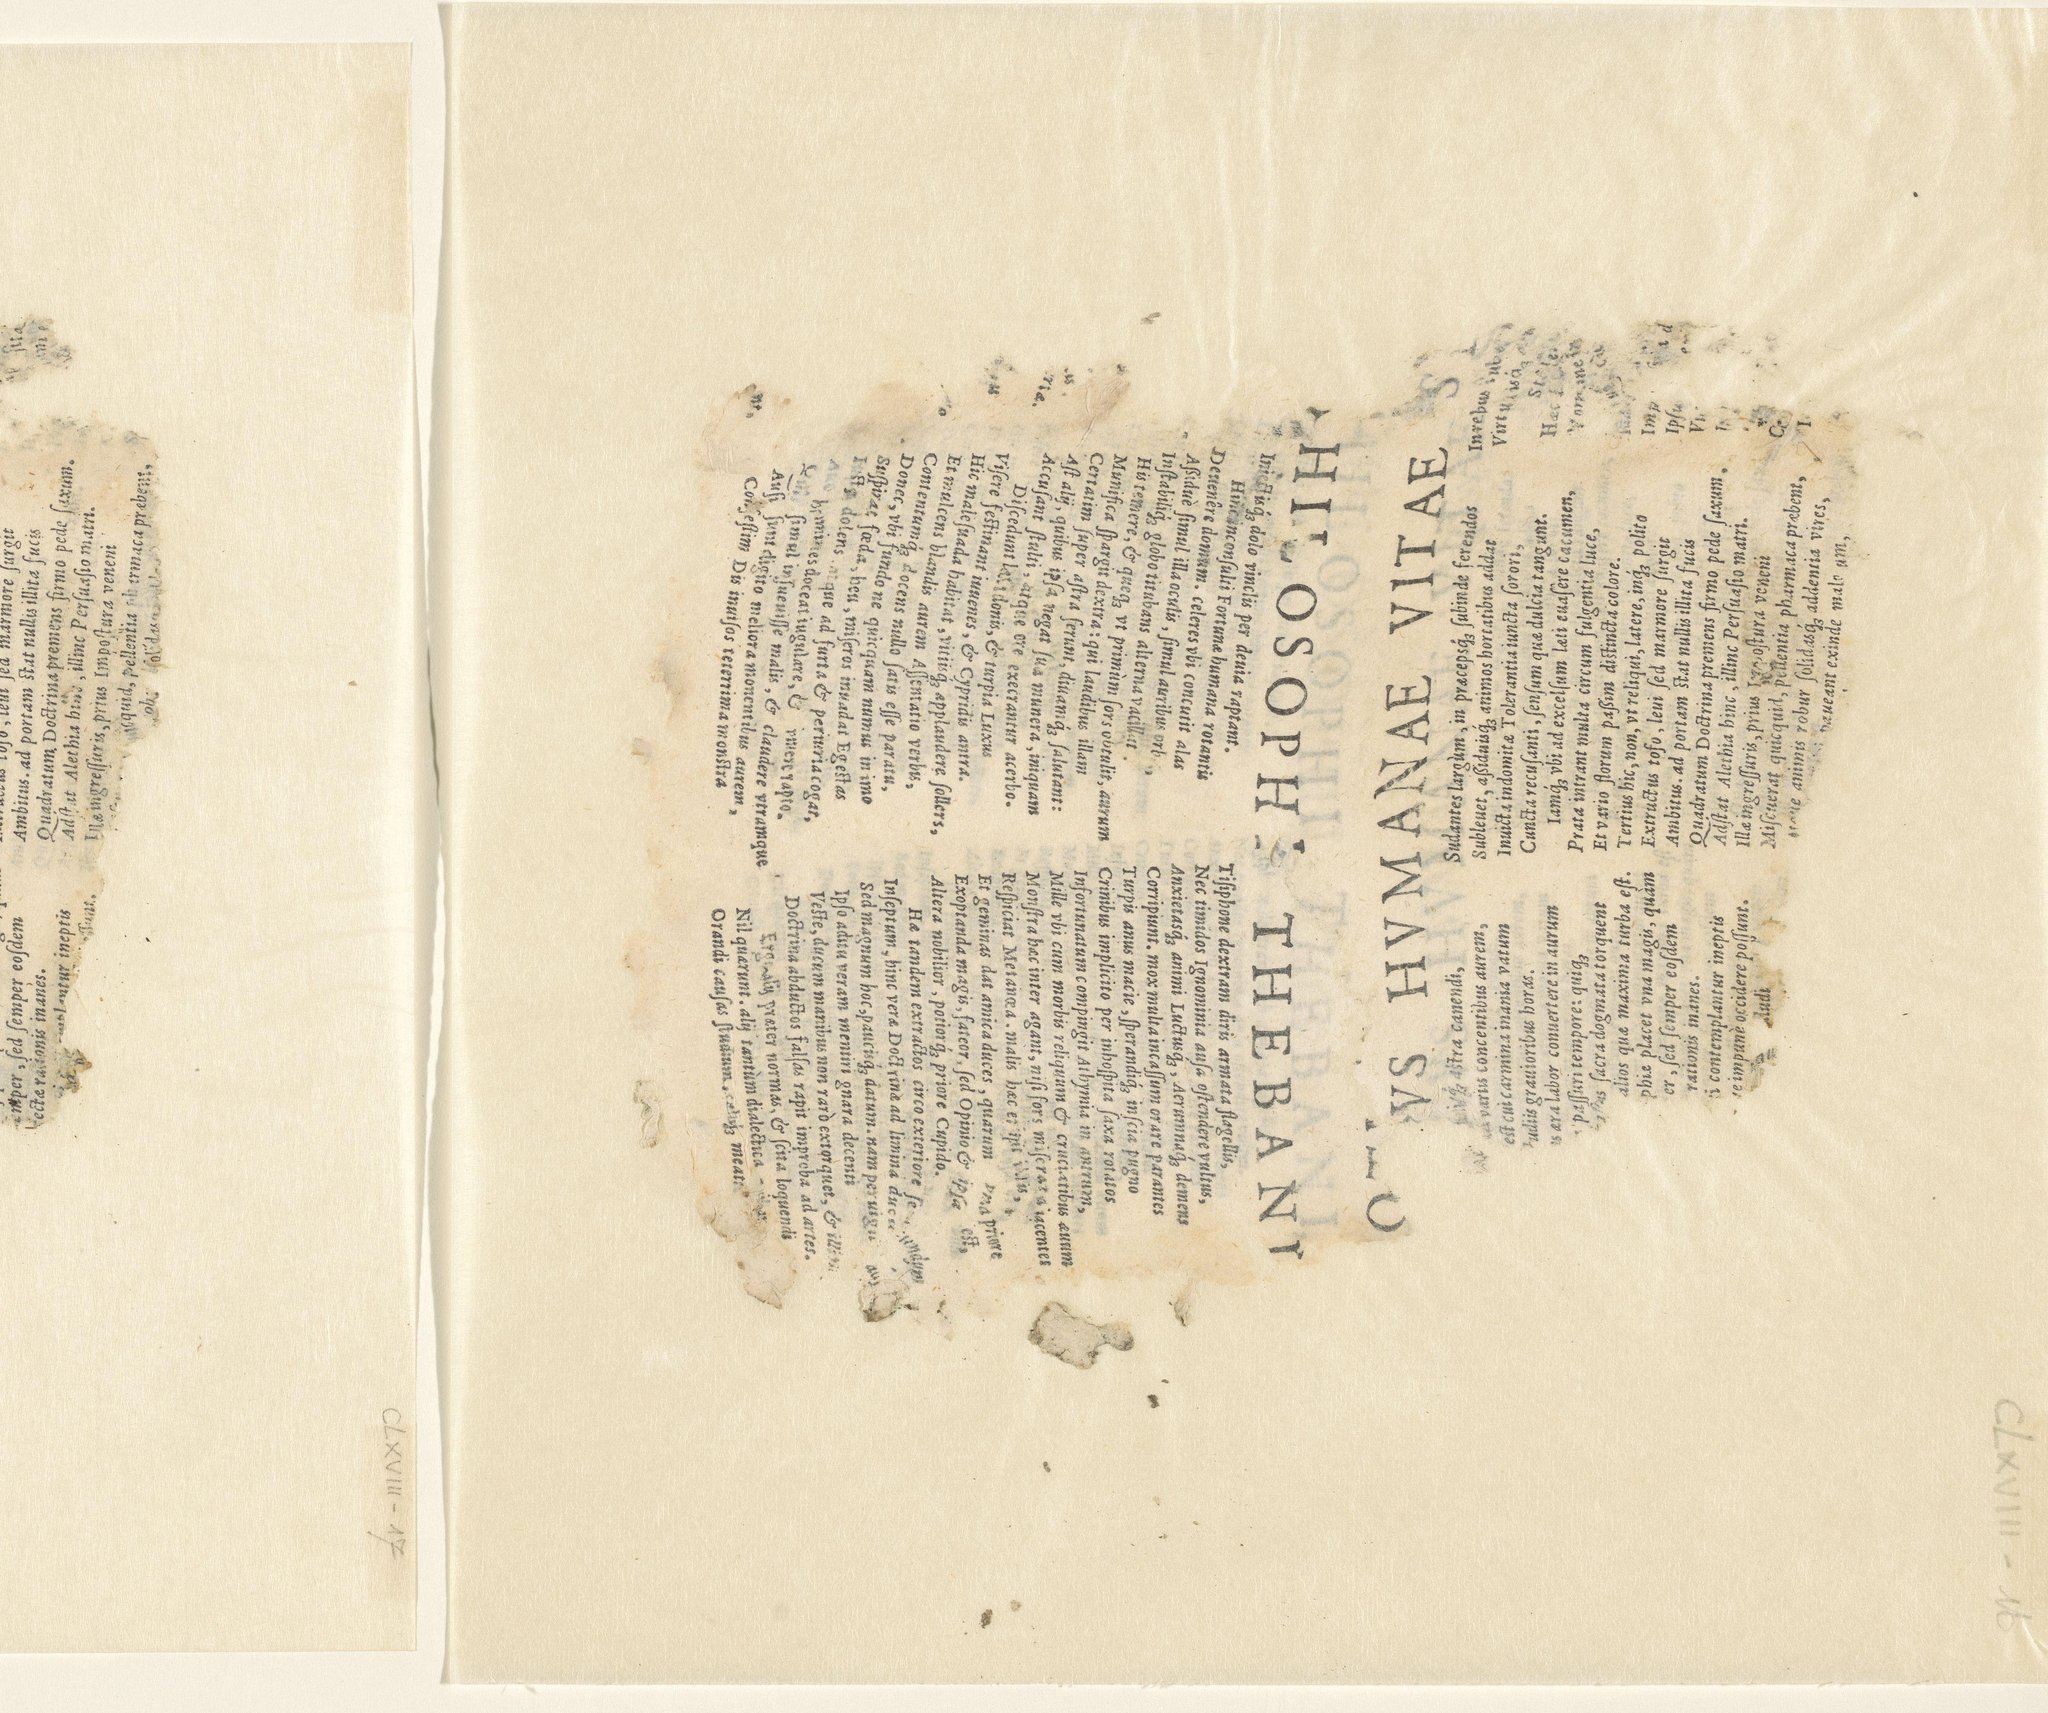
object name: text sheet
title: Tabula Cebetis Carta Vitae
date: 1561-1596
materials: paper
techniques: letterpress printing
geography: antwerp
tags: 'tabula cebetis'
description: Het tekstblad bestond origineel uit twee bladen. De prenten in de Nova Zembla collectie zijn tijdens een expeditie van Willem Barendsz en Jacob van Heemskerk in 1596-1597 noodgedwongen in het winterkamp, het ‘Behouden Huis’, op het eiland achtergelaten. De prenten waren in één of meerdere stapels als handelswaar meegenomen vanuit Amsterdam. Bijna drie eeuwen later, in 1871, keerde de Noor Elling Carlsen terug naar Nova Zembla en vond daar de restanten van het ‘Behouden Huis, inclusief een groot deel van de inventaris. Een deel van de prenten, in de vorm van aaneengekoekte kluiten, werd toen ook teruggevonden. De papierkluiten waren soms op meerdere plekken gebroken. Tussen 1975-1979 zijn de prenten van elkaar gescheiden. Dit leverde in totaal ca. 1000 fragmenten van ca. 400 afdrukken van ca. 150 verschillende prenten op. Voor zover mogelijk zijn de fragmenten samengevoegd en zijn de prenten gereconstrueerd.